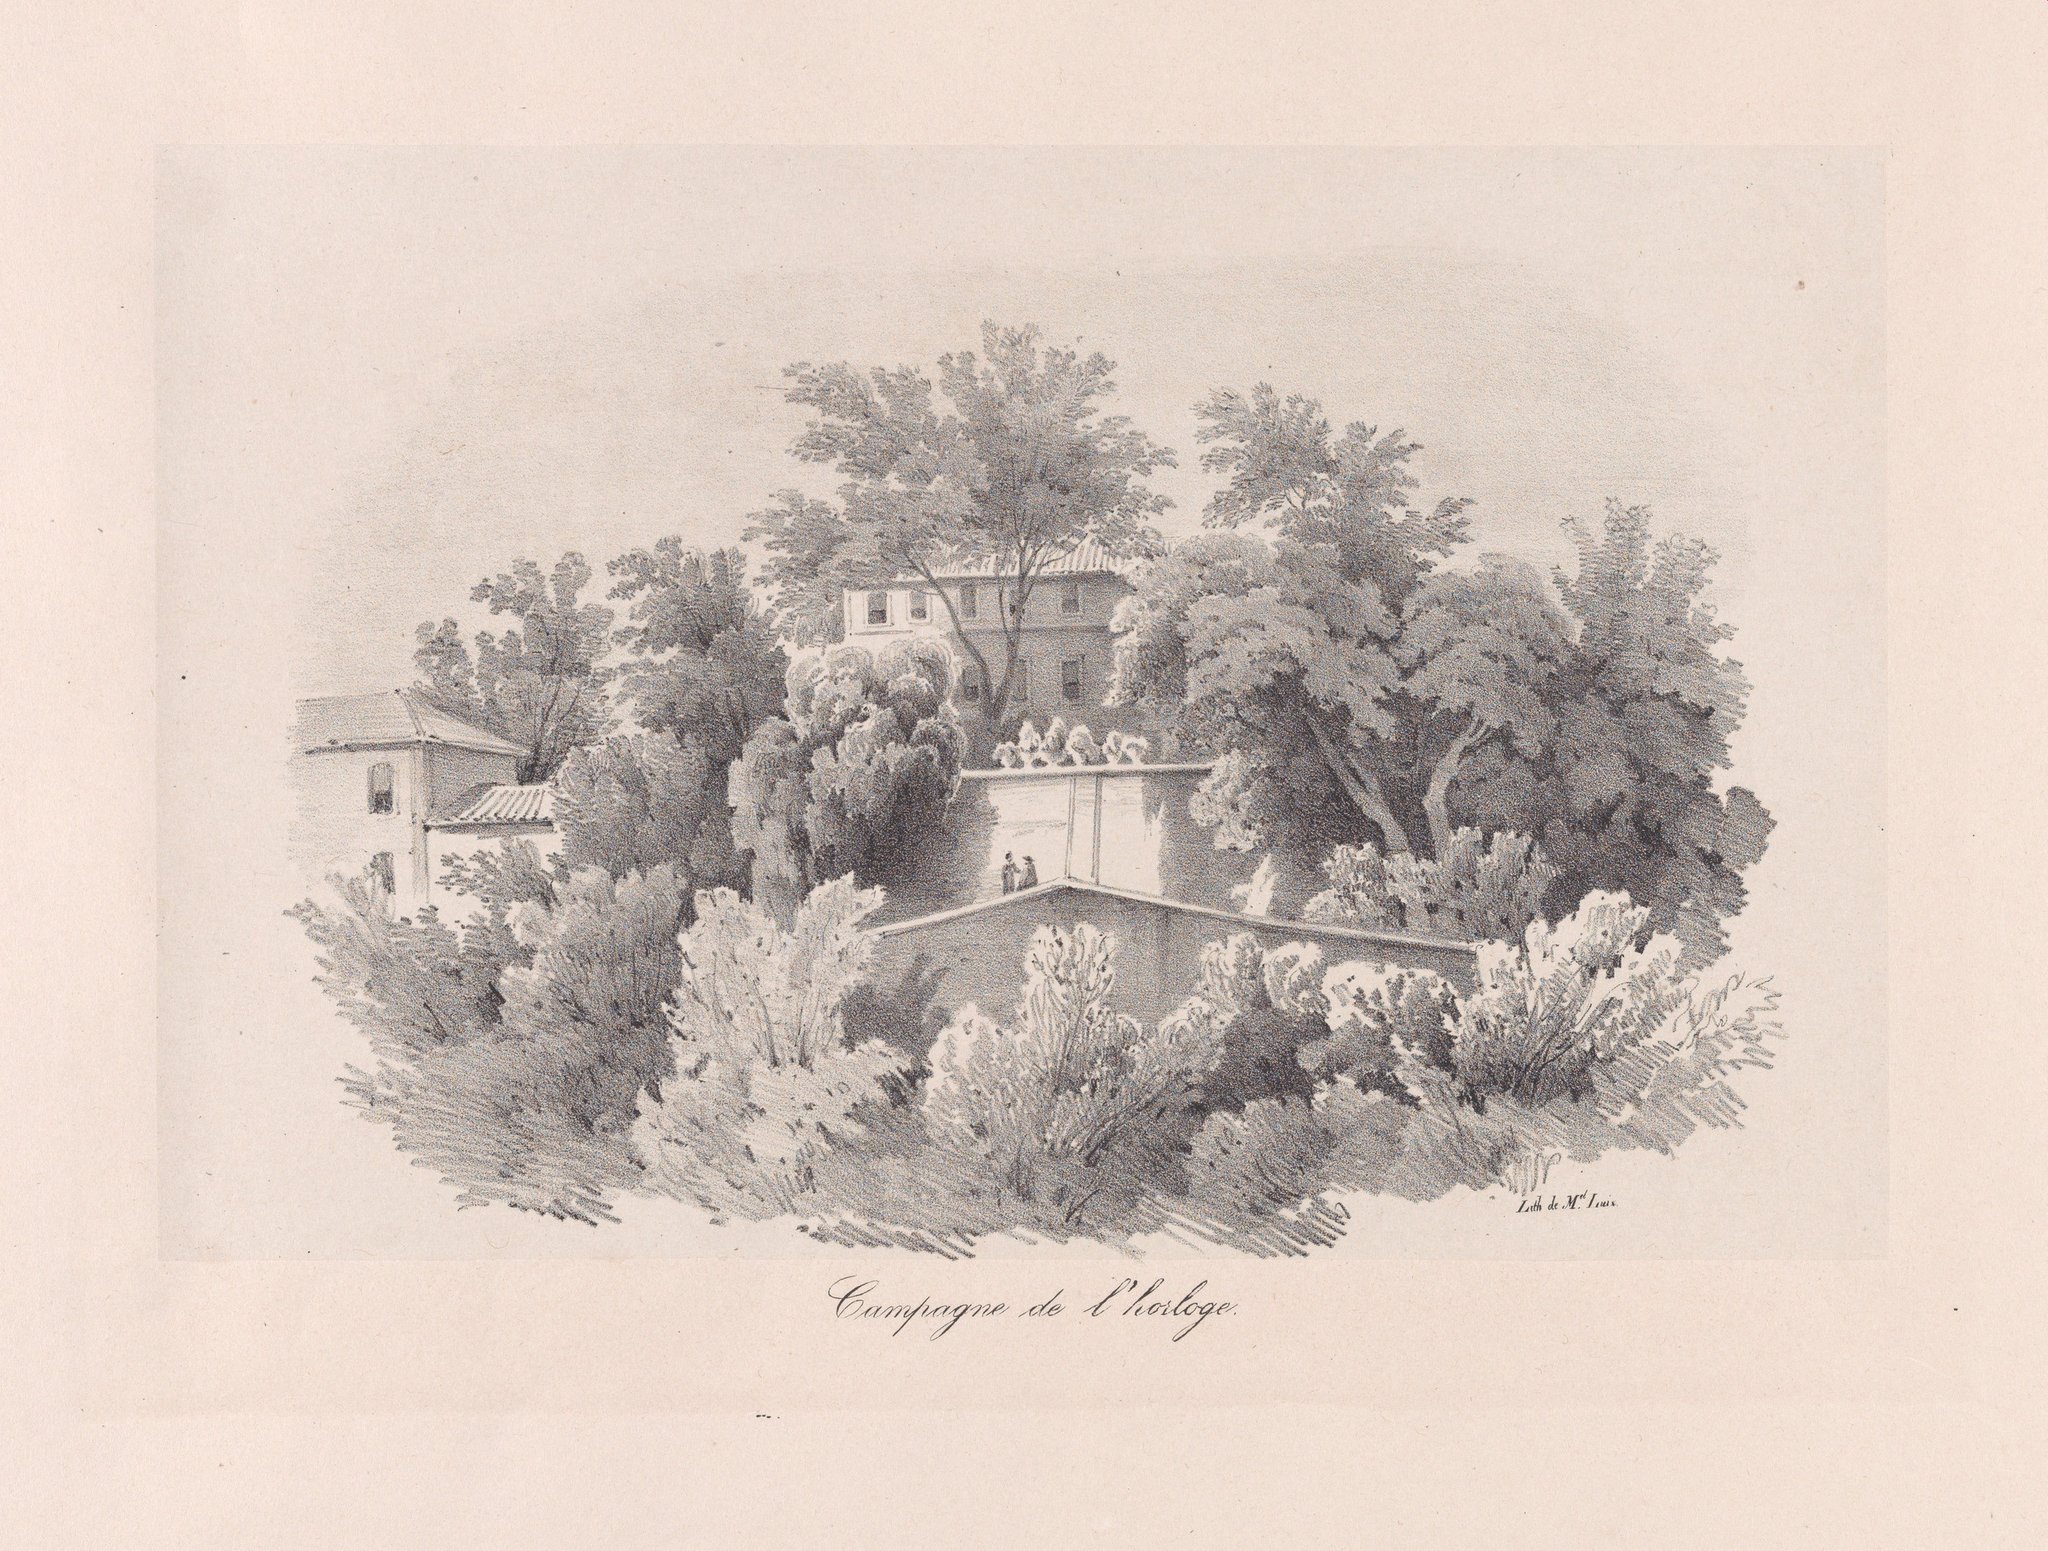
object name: print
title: View of Sintra, the area near the clock-tower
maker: clementine de brelaz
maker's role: artist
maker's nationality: portuguese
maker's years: 1811-1892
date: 1840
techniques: printmaking, lithograph